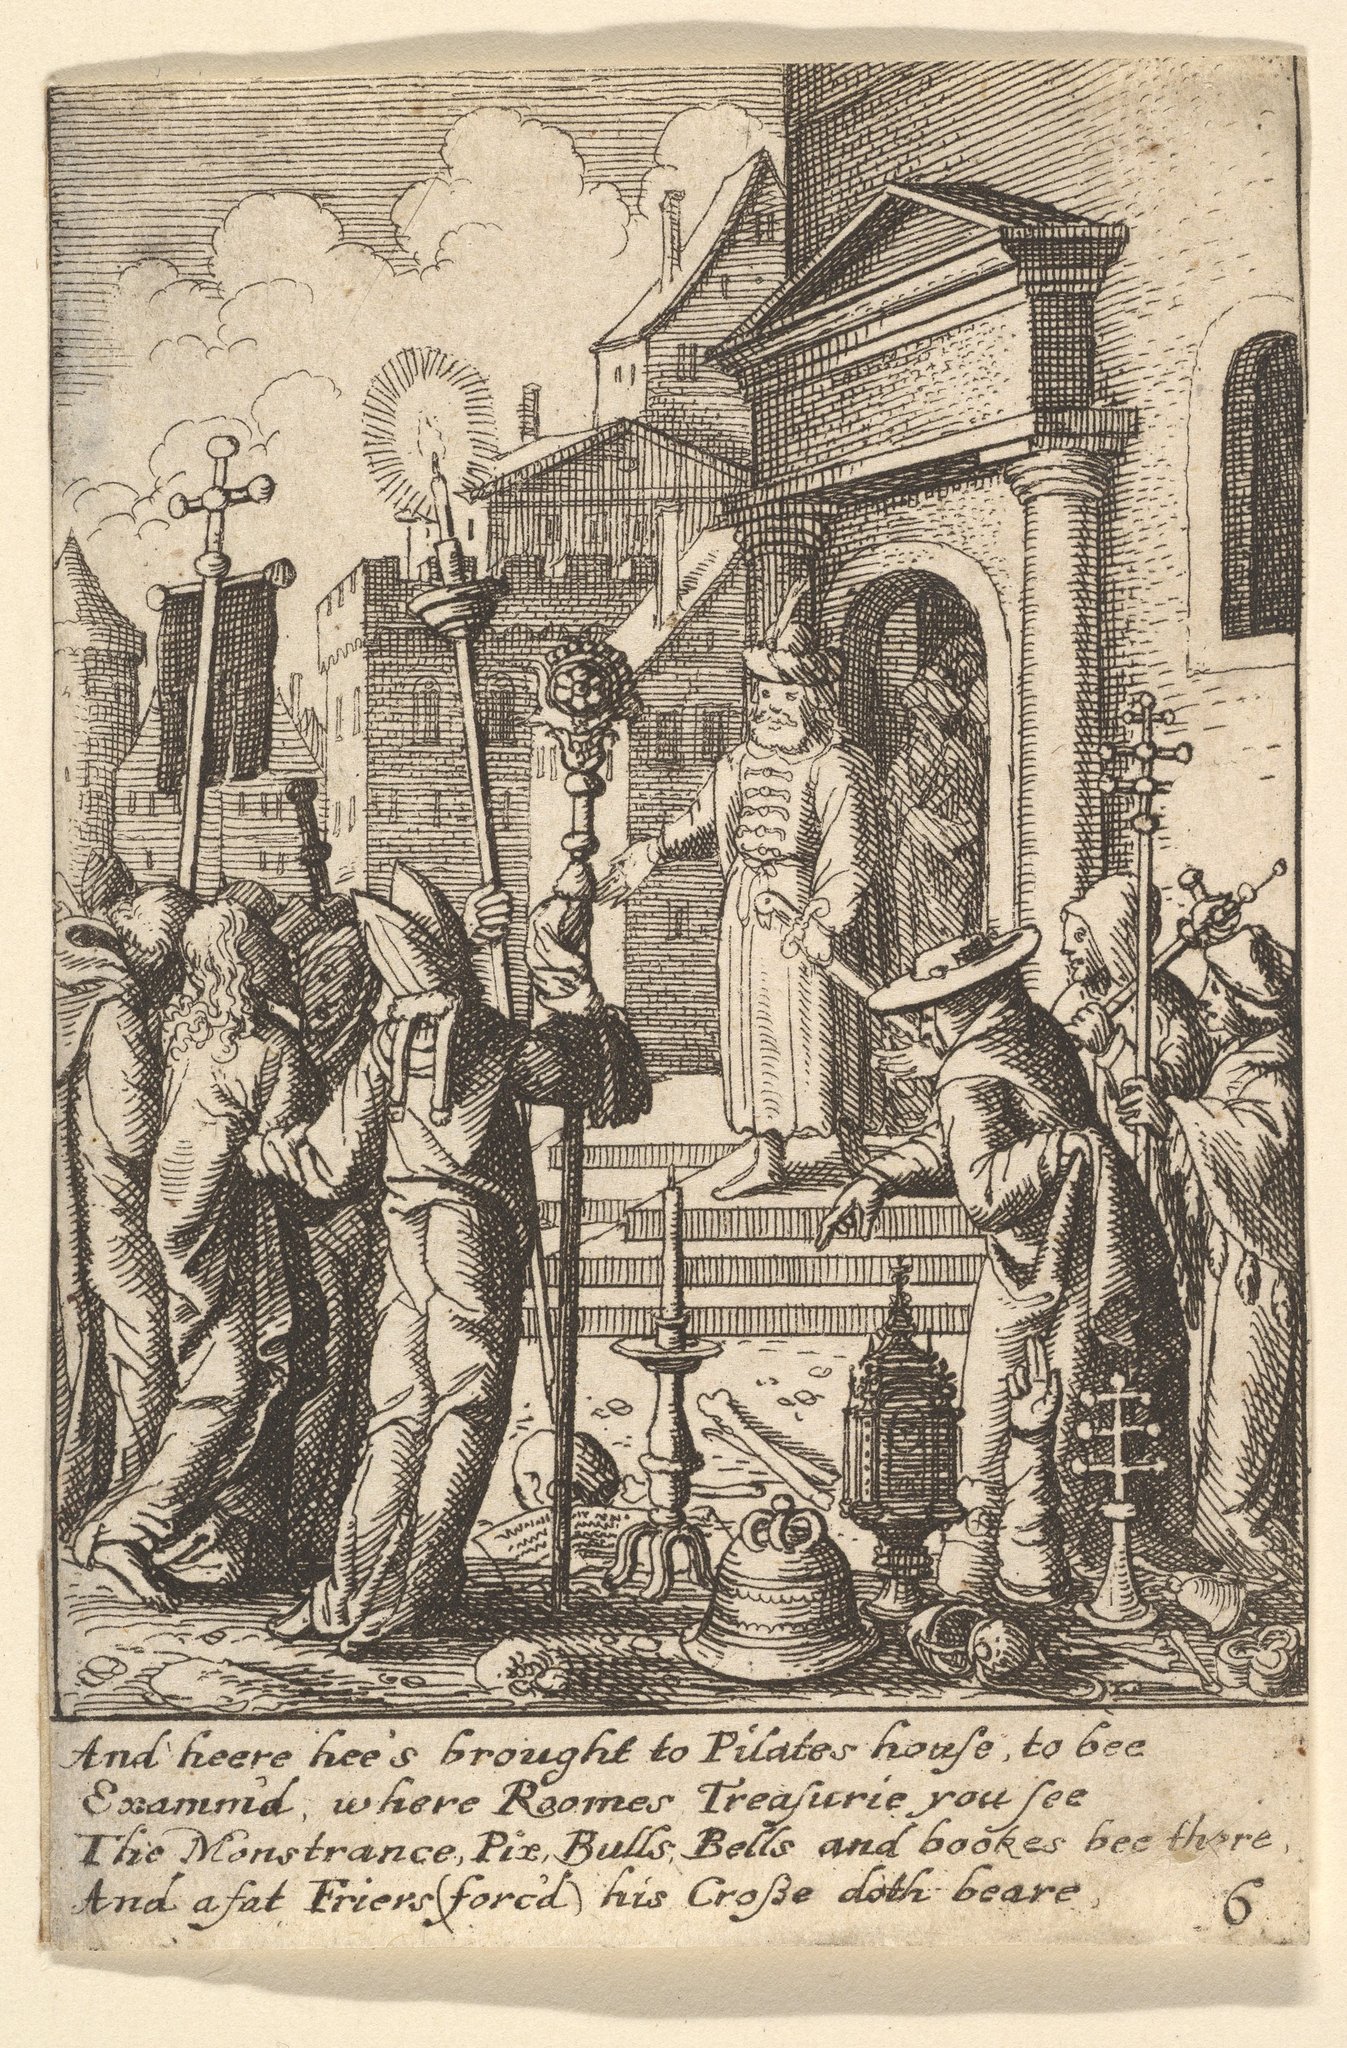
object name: print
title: Jesus before Pilate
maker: wenceslaus hollar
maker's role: artist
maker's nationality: bohemian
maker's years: 1607-1677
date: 1677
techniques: etching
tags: men,women,jesus